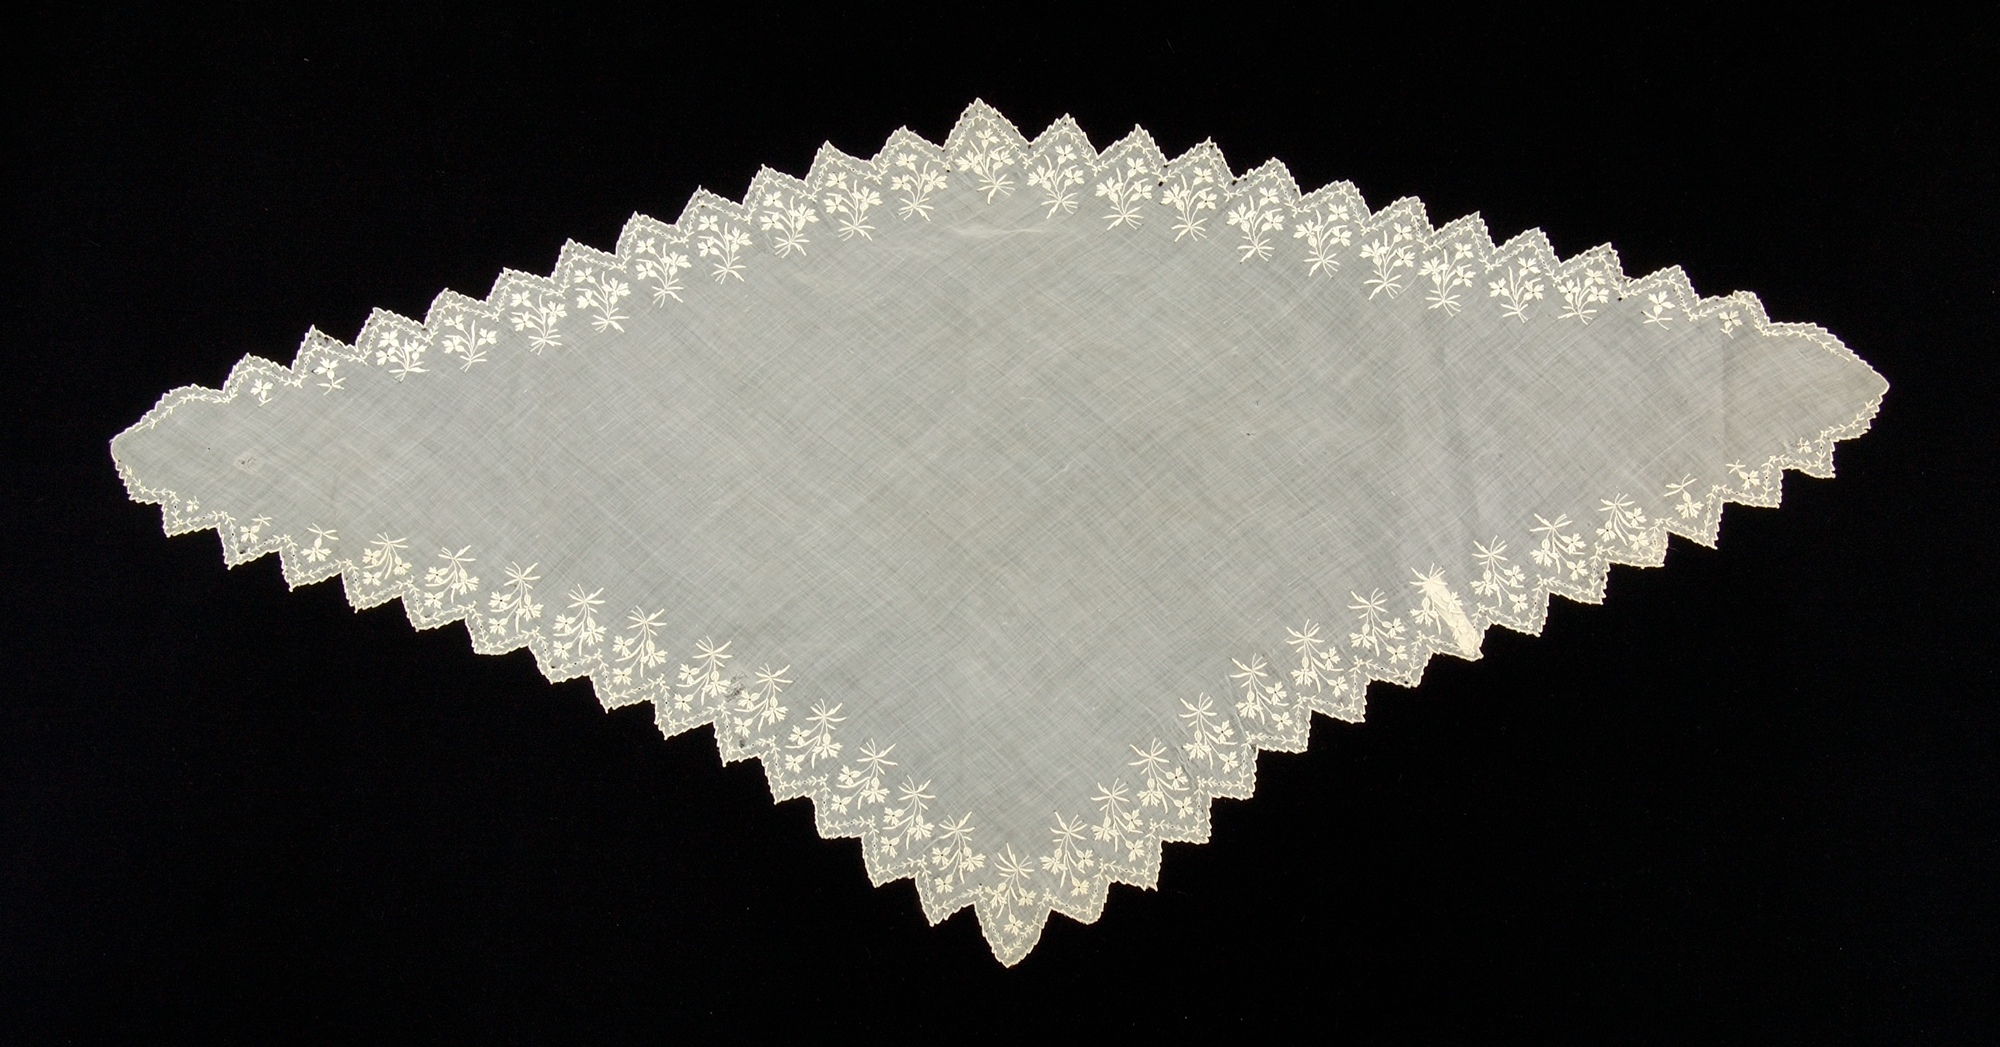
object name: fichu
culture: american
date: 1830-1840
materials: cotton